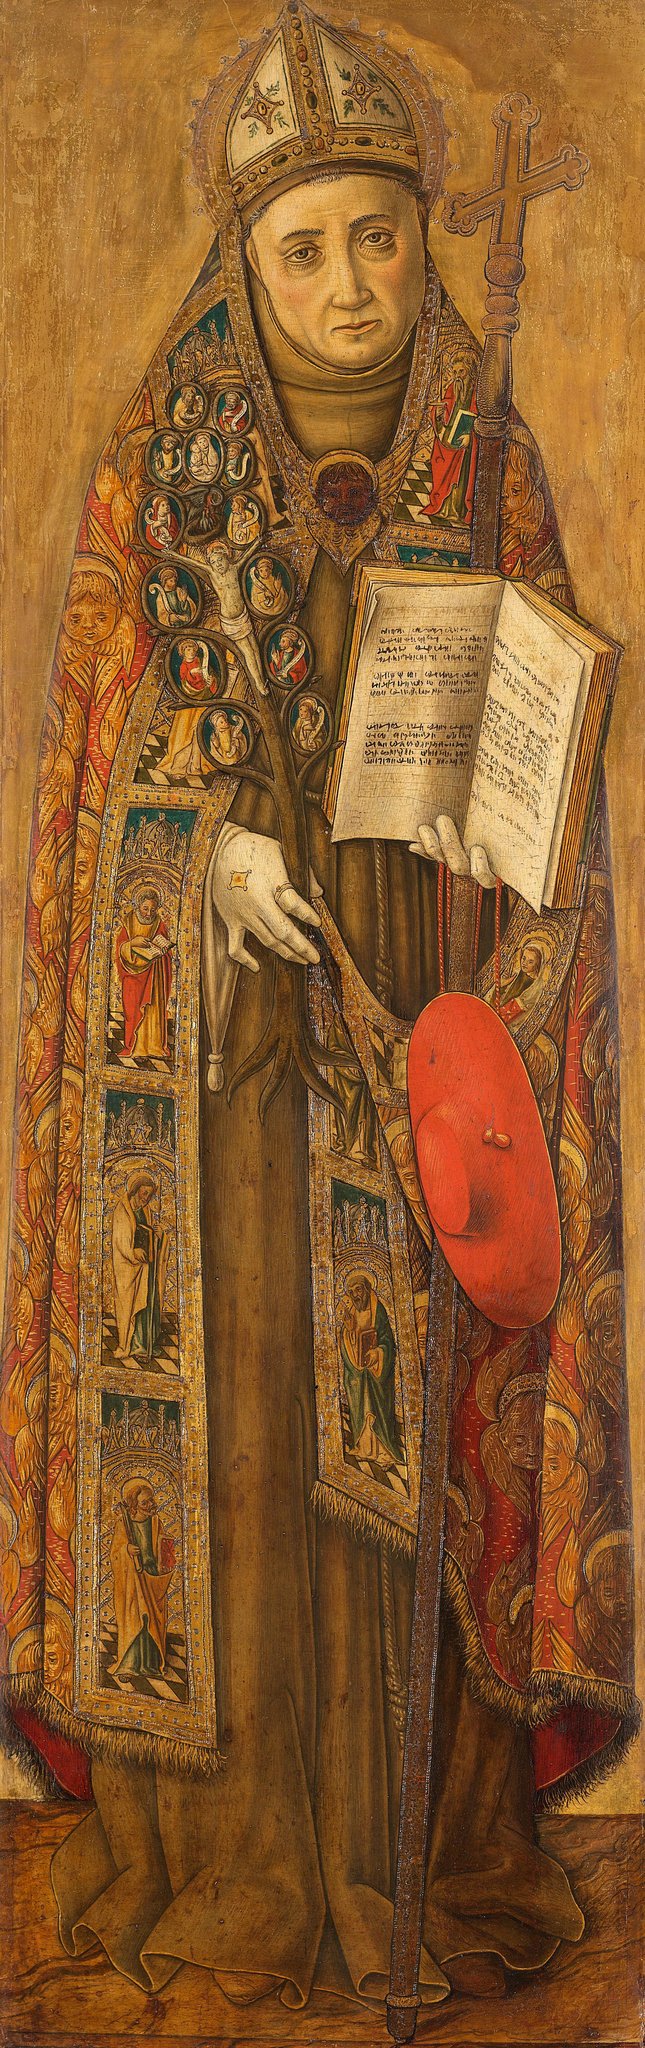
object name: painting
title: St Bonaventura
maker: vittore crivelli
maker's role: painter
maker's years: 1440-1502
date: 1481-1502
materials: panel, paint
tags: bonaventura, cardinal bishop of albano and minister general of the franciscan order; possible attributes: book, cardinal's hat (sometimes hanging from a tree), crucifix (sometimes flowering)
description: De heilige Bonaventura. Staand met een staf, een kardinaalshoed en een opengeslagen boek in de linkerhand, het Lignum Vitae in de rechterhand. De rand van zijn mantel is versierd met afbeeldingen van apostelen. Pendant van SK-A-3390.